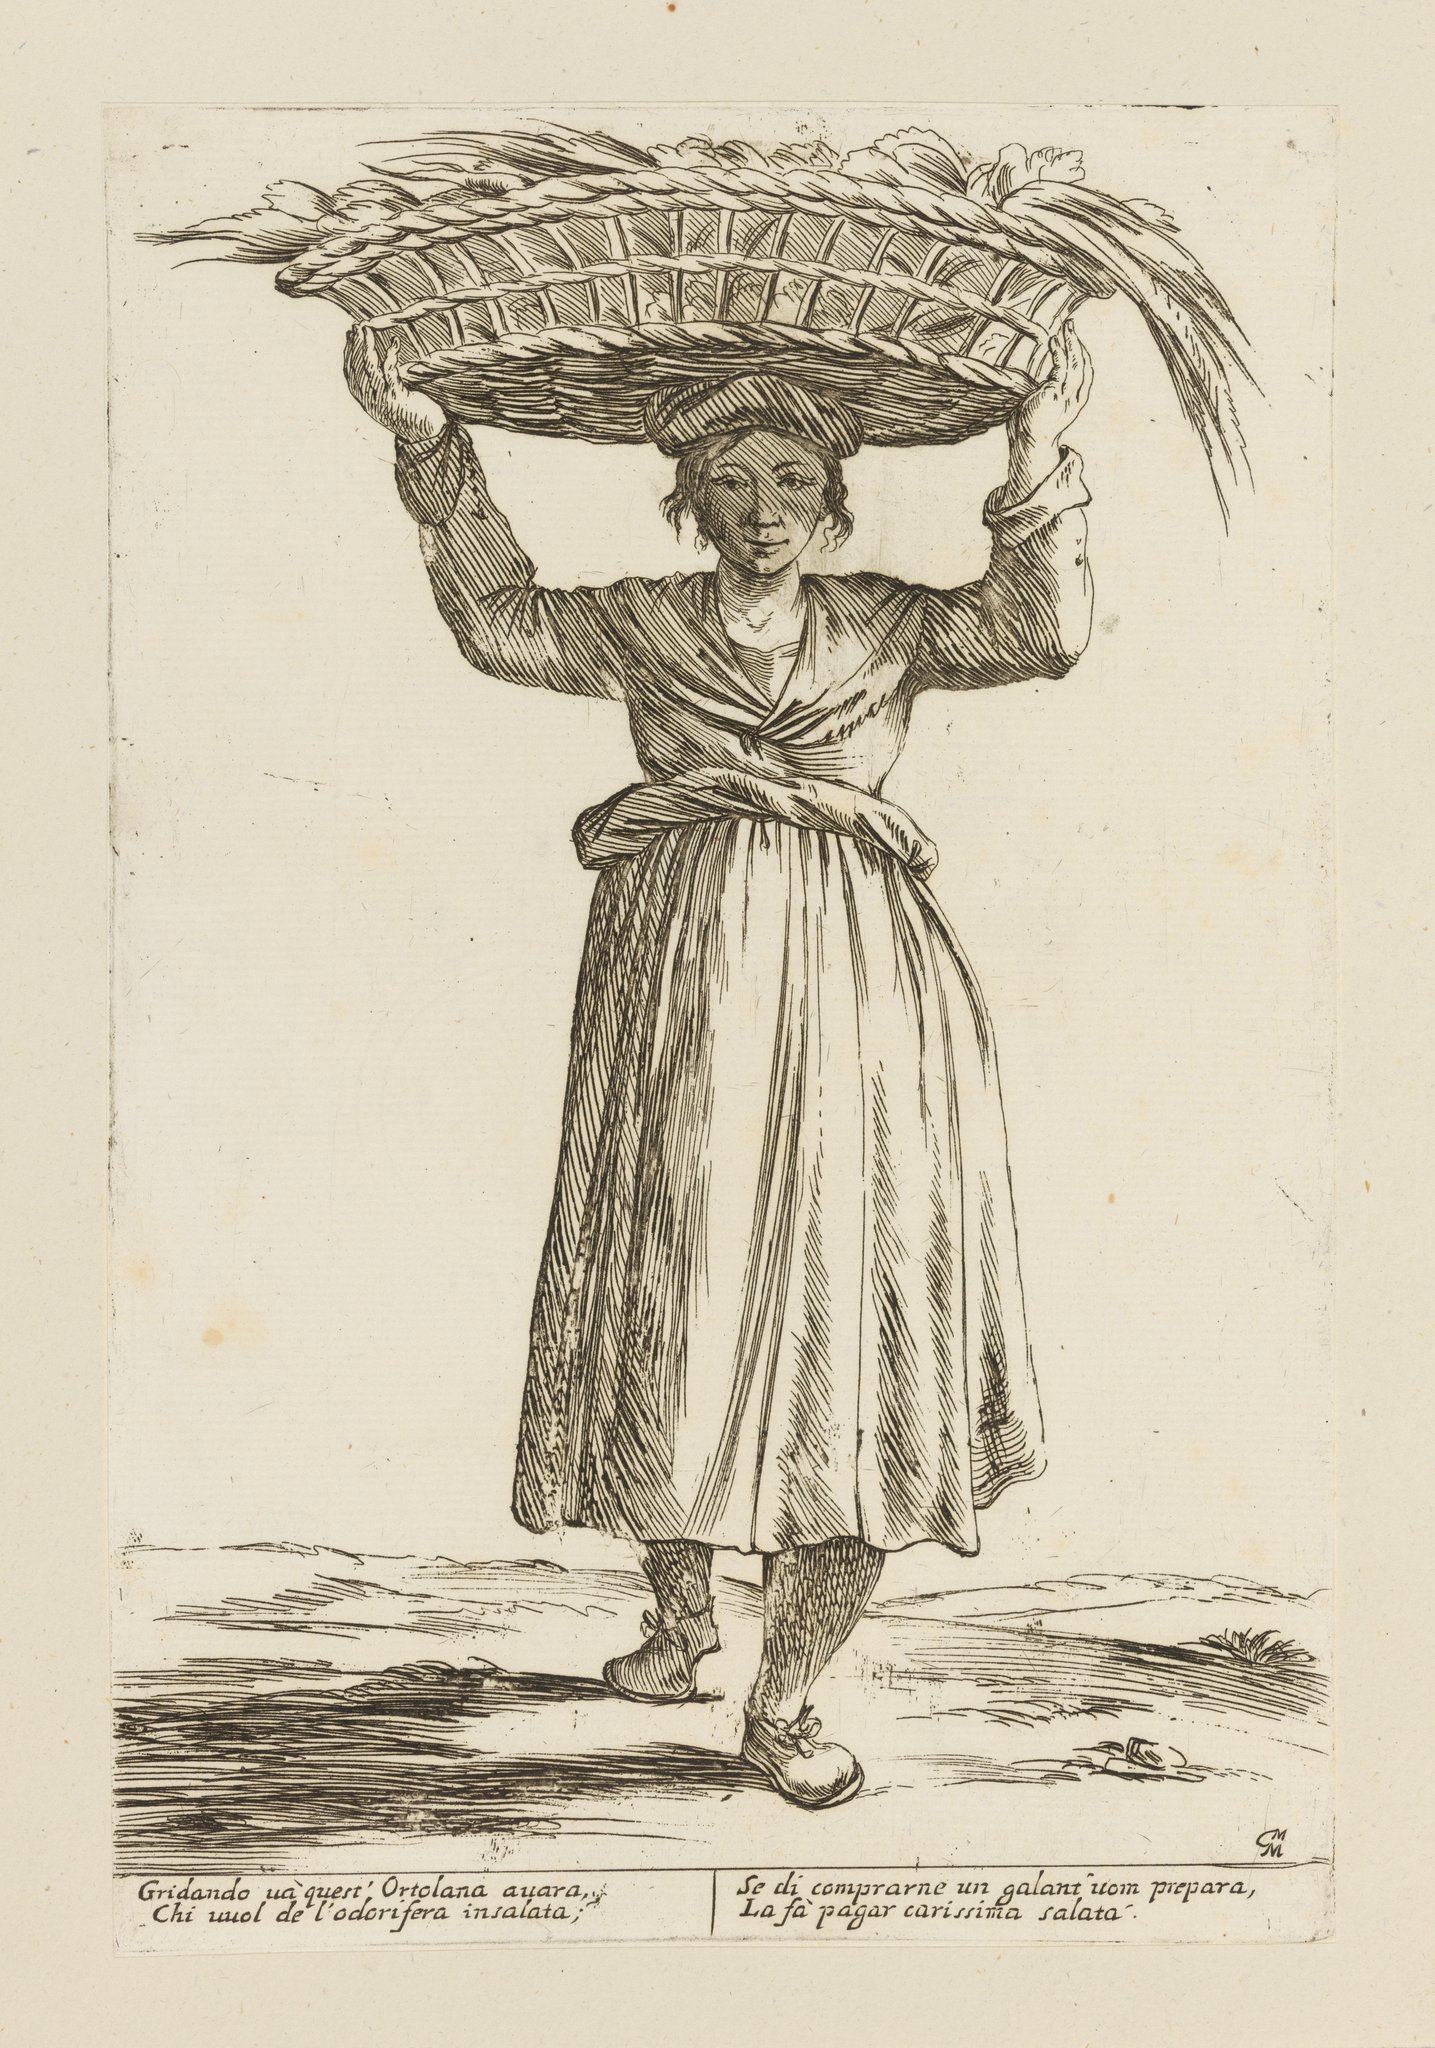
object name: print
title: Vegetable Vendor, from Di Bologna l'Arti per via D'An.ibal' Ca.rac, plate 24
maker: giuseppe maria mitelli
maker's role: artist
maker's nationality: italian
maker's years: 1634-1718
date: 1660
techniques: etching